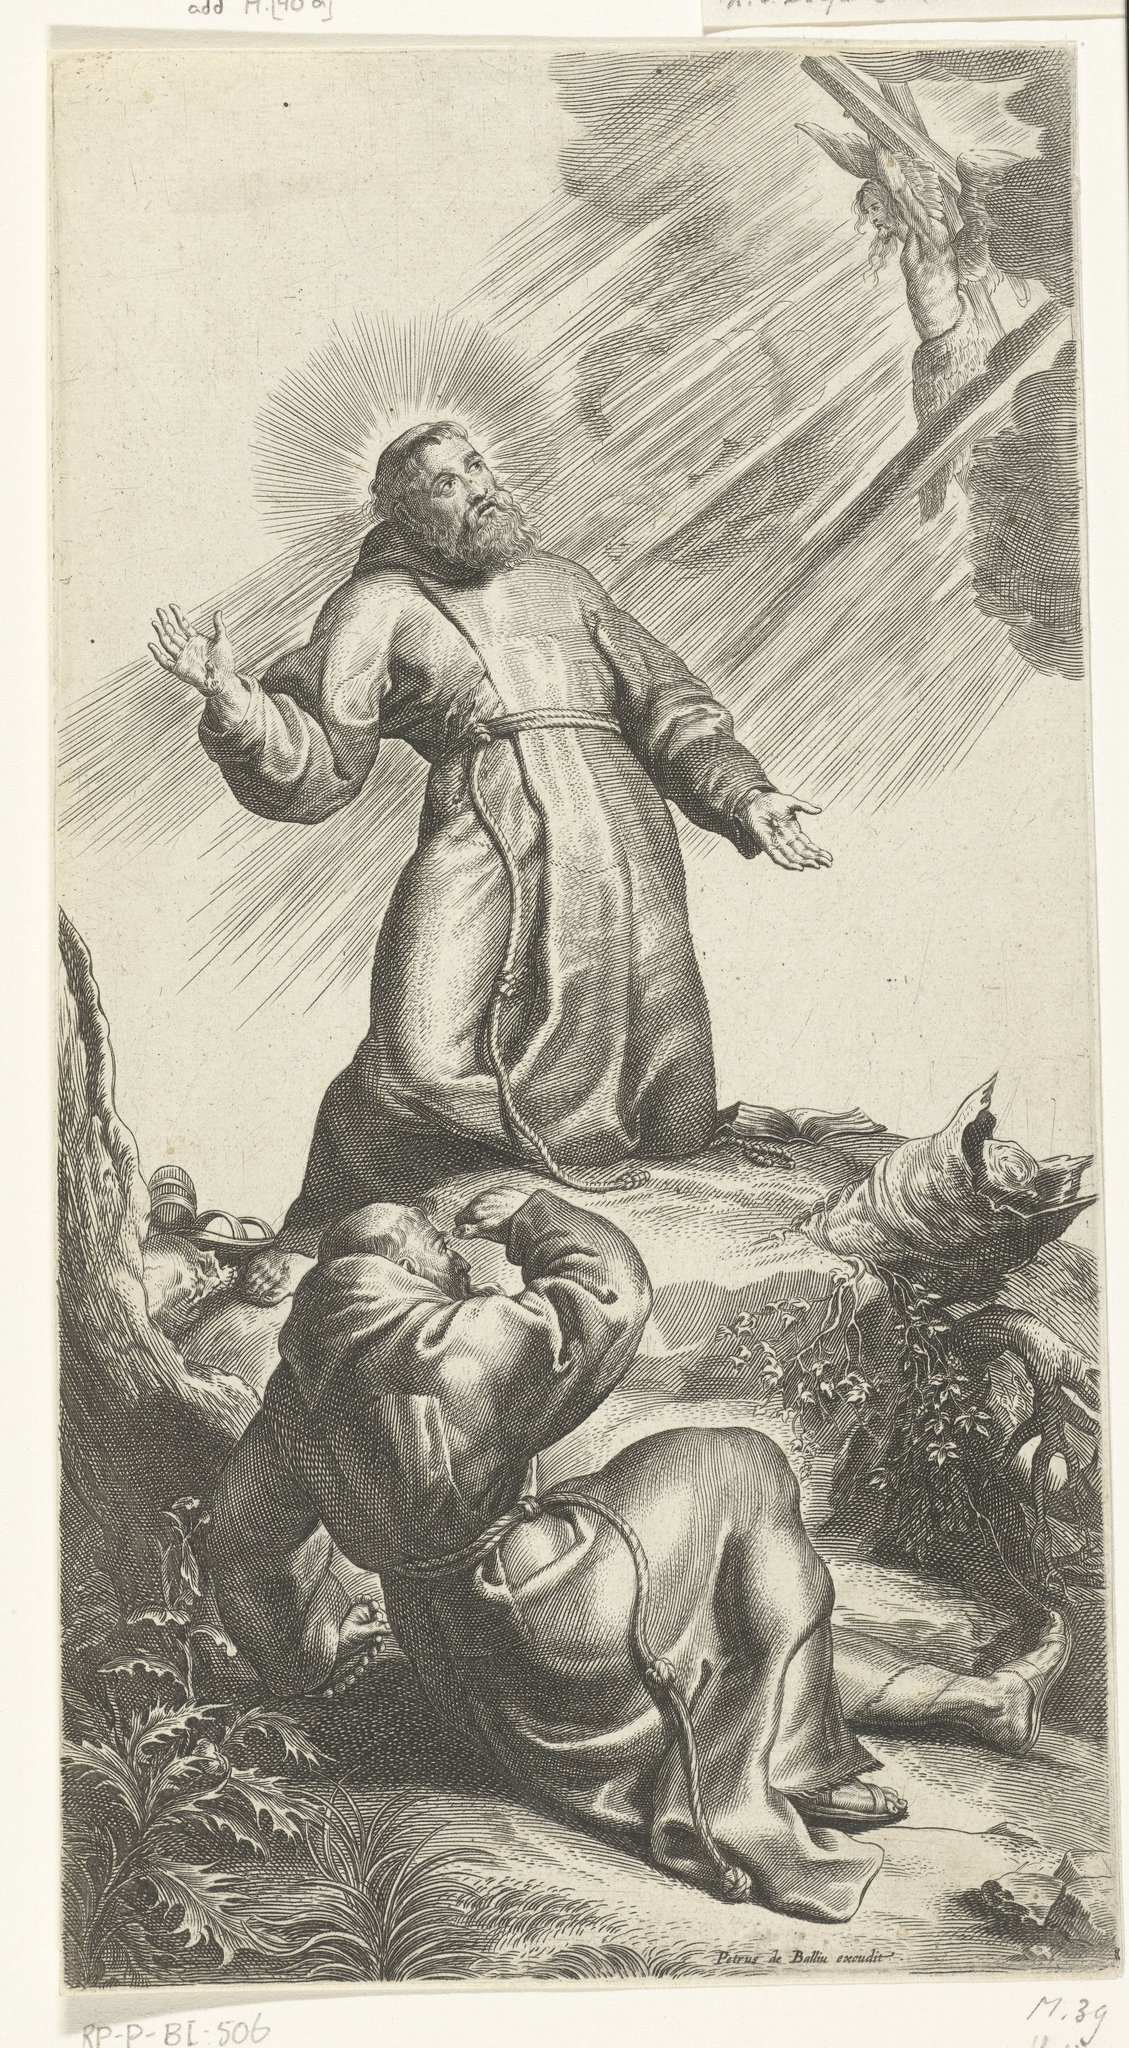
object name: print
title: Franciscus van Assisi ontvangt stigmata van Christus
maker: pieter de bailliu (i)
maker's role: print maker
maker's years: 1613-1660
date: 1623-1660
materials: paper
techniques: engraving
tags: stigmatization of st. francis of assisi: in retreat on mount alverna, he beholds a vision of christ on the cross enveloped by wings (like a seraph with six wings); rays passing down to the body of the kneeling saint form the marks of the five wounds of christ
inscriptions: collector's mark: Lugt 2228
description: Franciscus van Assisi ontvangt stigmata van Christus en aan hemel verschijnt Christus aan het kruis met zes vleugels (als serafijn).